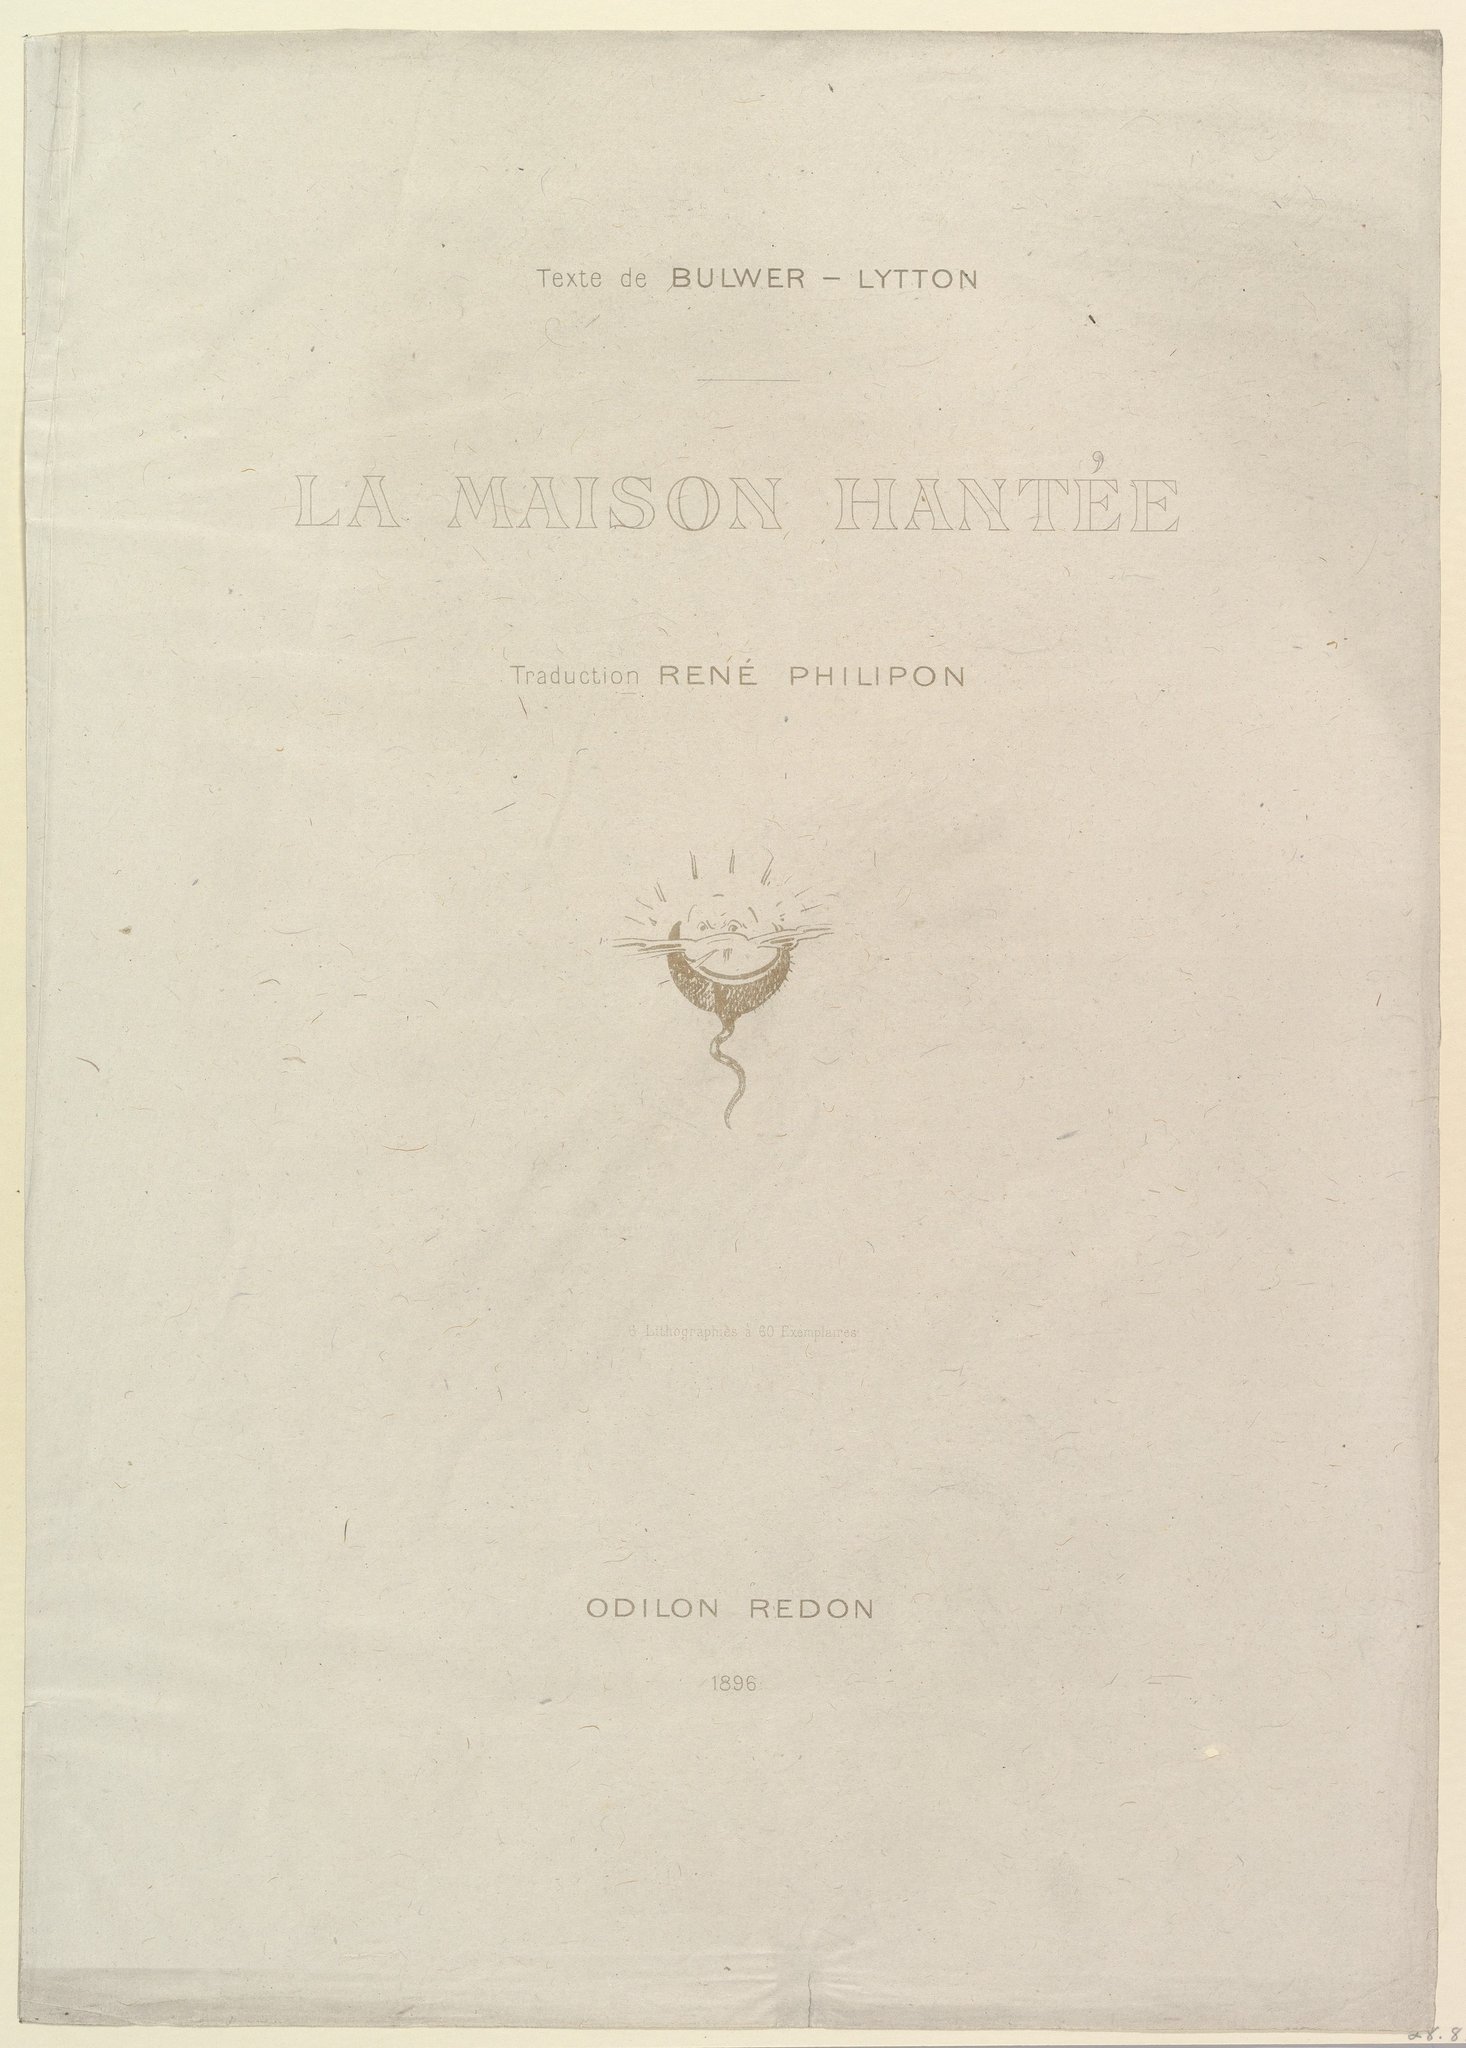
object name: print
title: Title page to the series, The Haunted House (La Maison Hantée)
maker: odilon redon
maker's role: artist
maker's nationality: french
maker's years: 1840-1916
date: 1896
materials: paper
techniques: lithograph